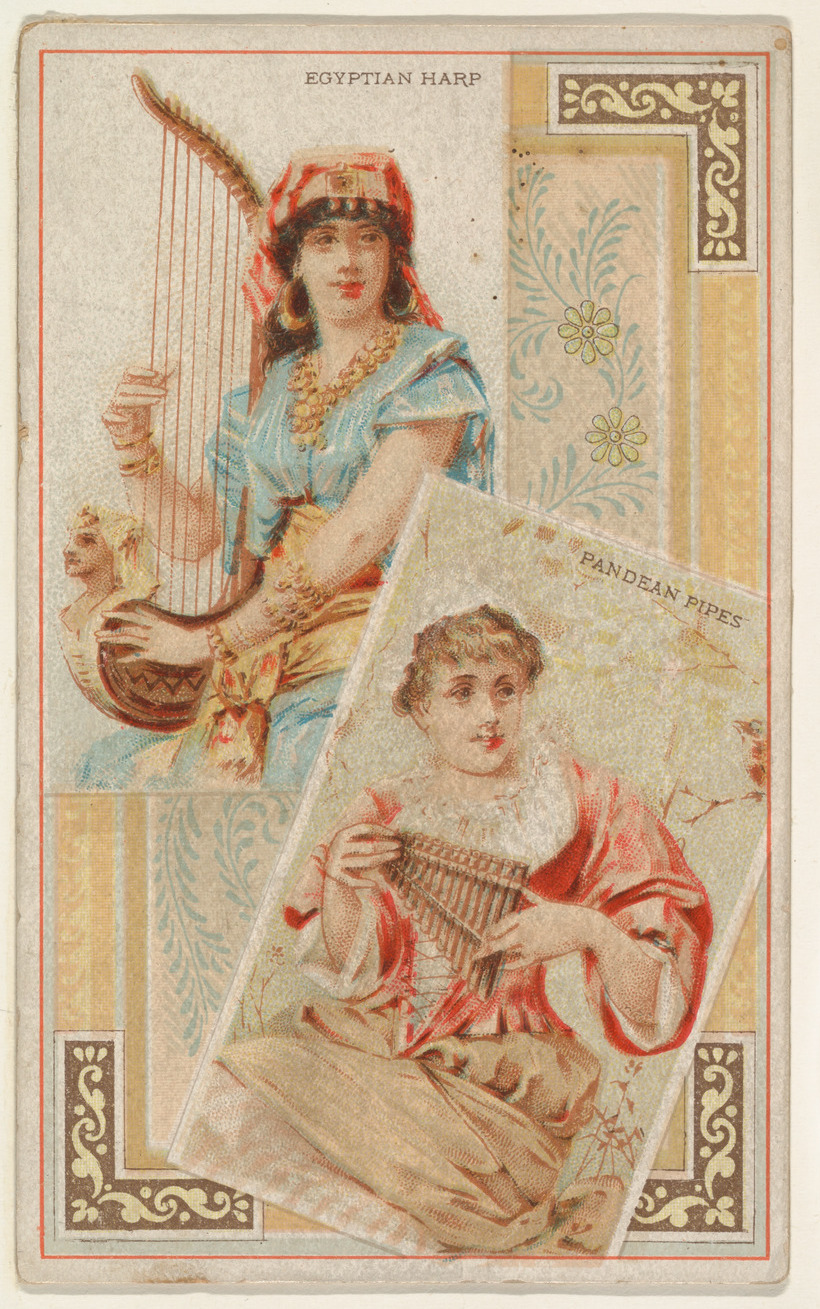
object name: print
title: Egyptian Harp and Pandean Pipes, from the Musical Instruments series (N121) issued by Duke Sons & Co. to promote Honest Long Cut Tobacco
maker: w. duke, sons & co.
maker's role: publisher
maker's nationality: american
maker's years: 1870-1920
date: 1888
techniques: color lithograph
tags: women,harps